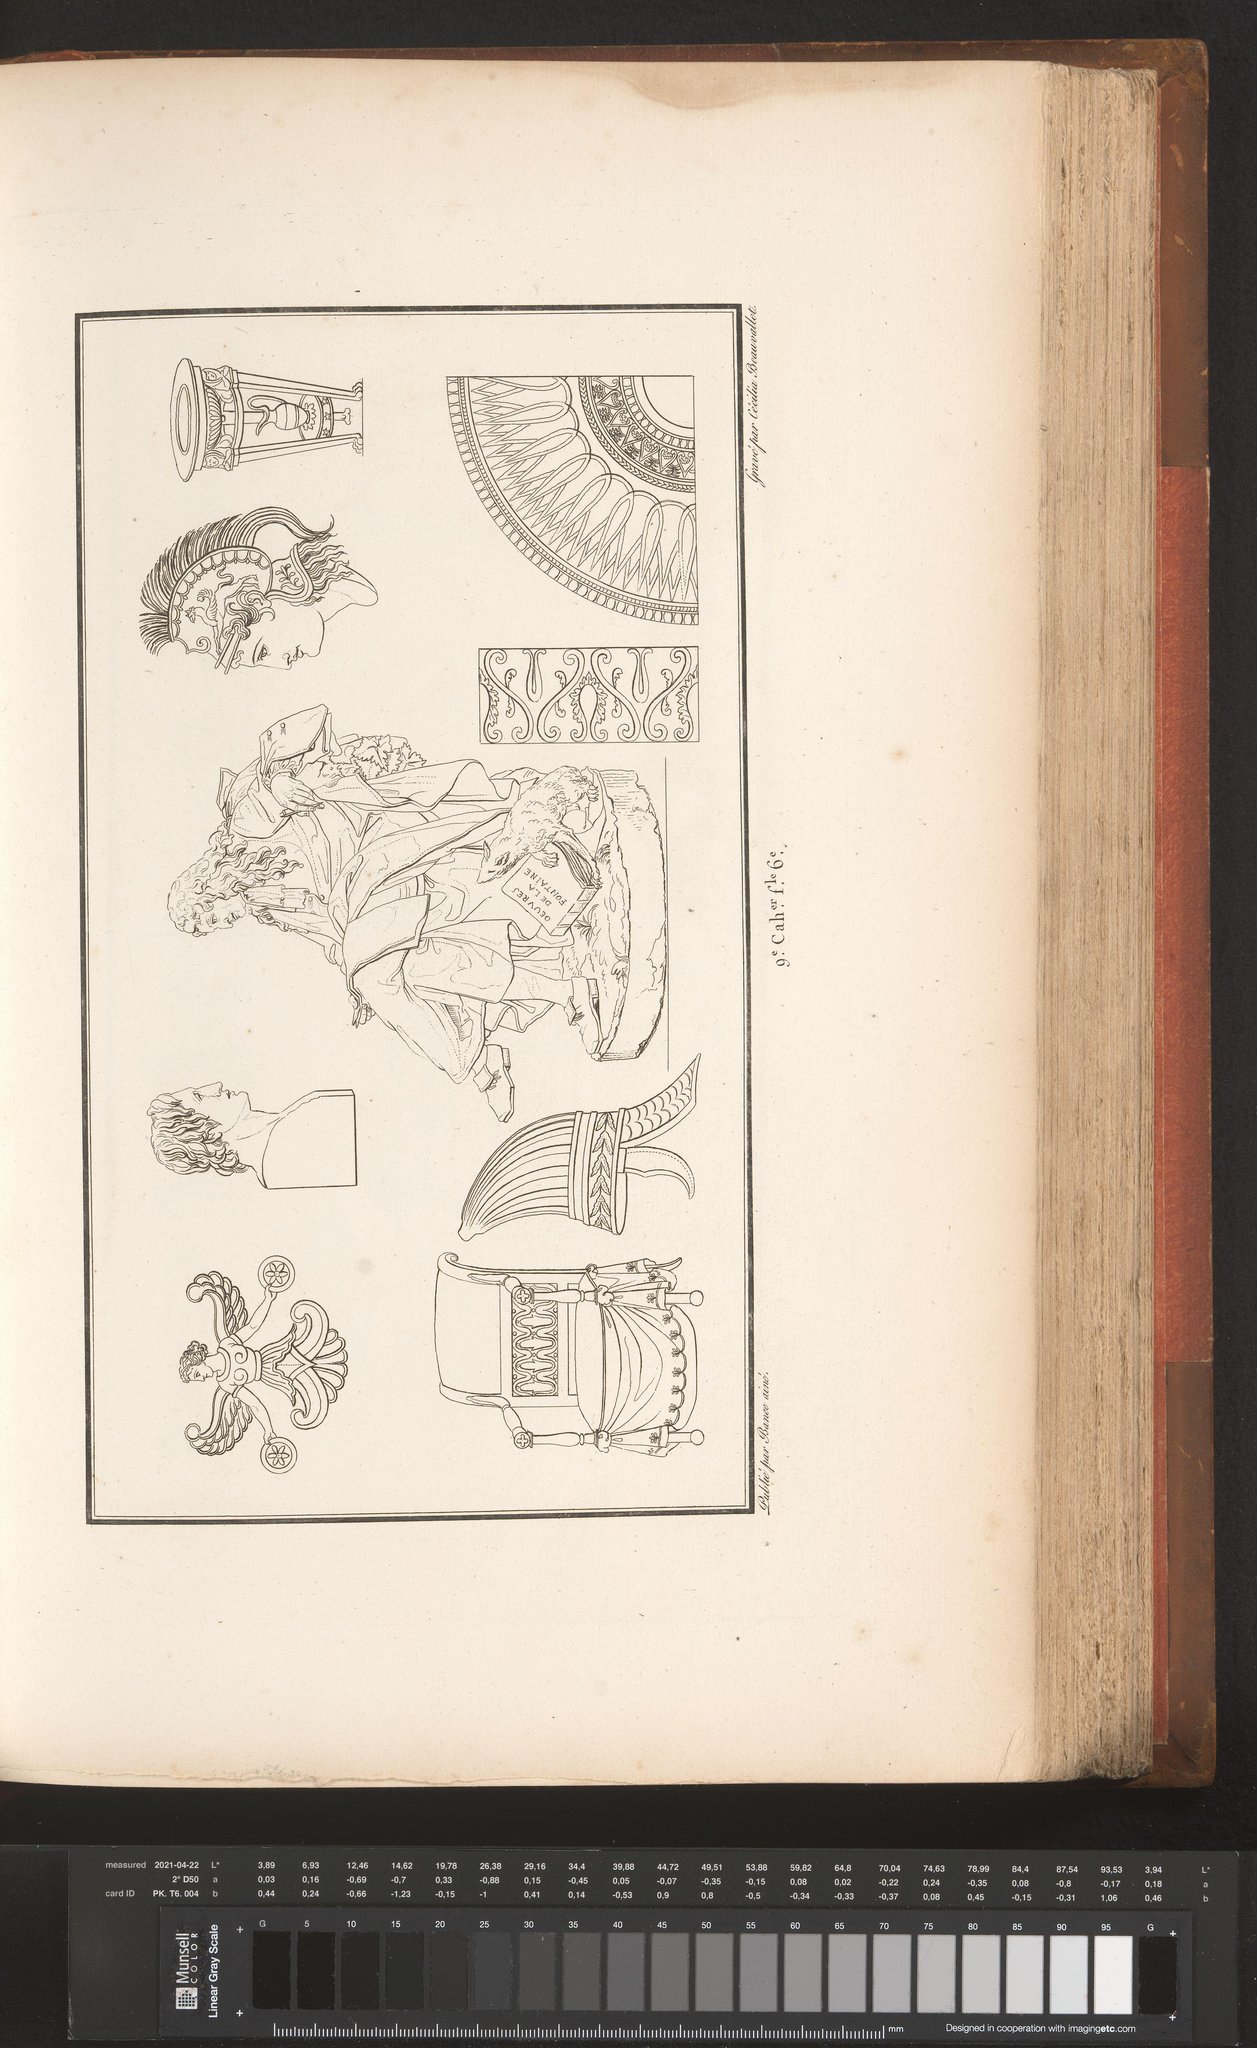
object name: ornament print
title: Diverse ornamenten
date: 1820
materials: paper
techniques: etching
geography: paris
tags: jean de la fontaine, ornaments ~ art, piece of sculpture, reproduction of a piece of sculpture, writer, poet, author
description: Ornamentprent met diverse objecten, centraal het beeld van de zittende schrijver Jean de la Fontaine door Pierre Julien, in het Louvre. Onderdeel van het prentalbum met twee series van in totaal 138 ornamentprenten door Beauvallet en Normand, 'Fragmens d'Ornemens dans le Style Antique'.